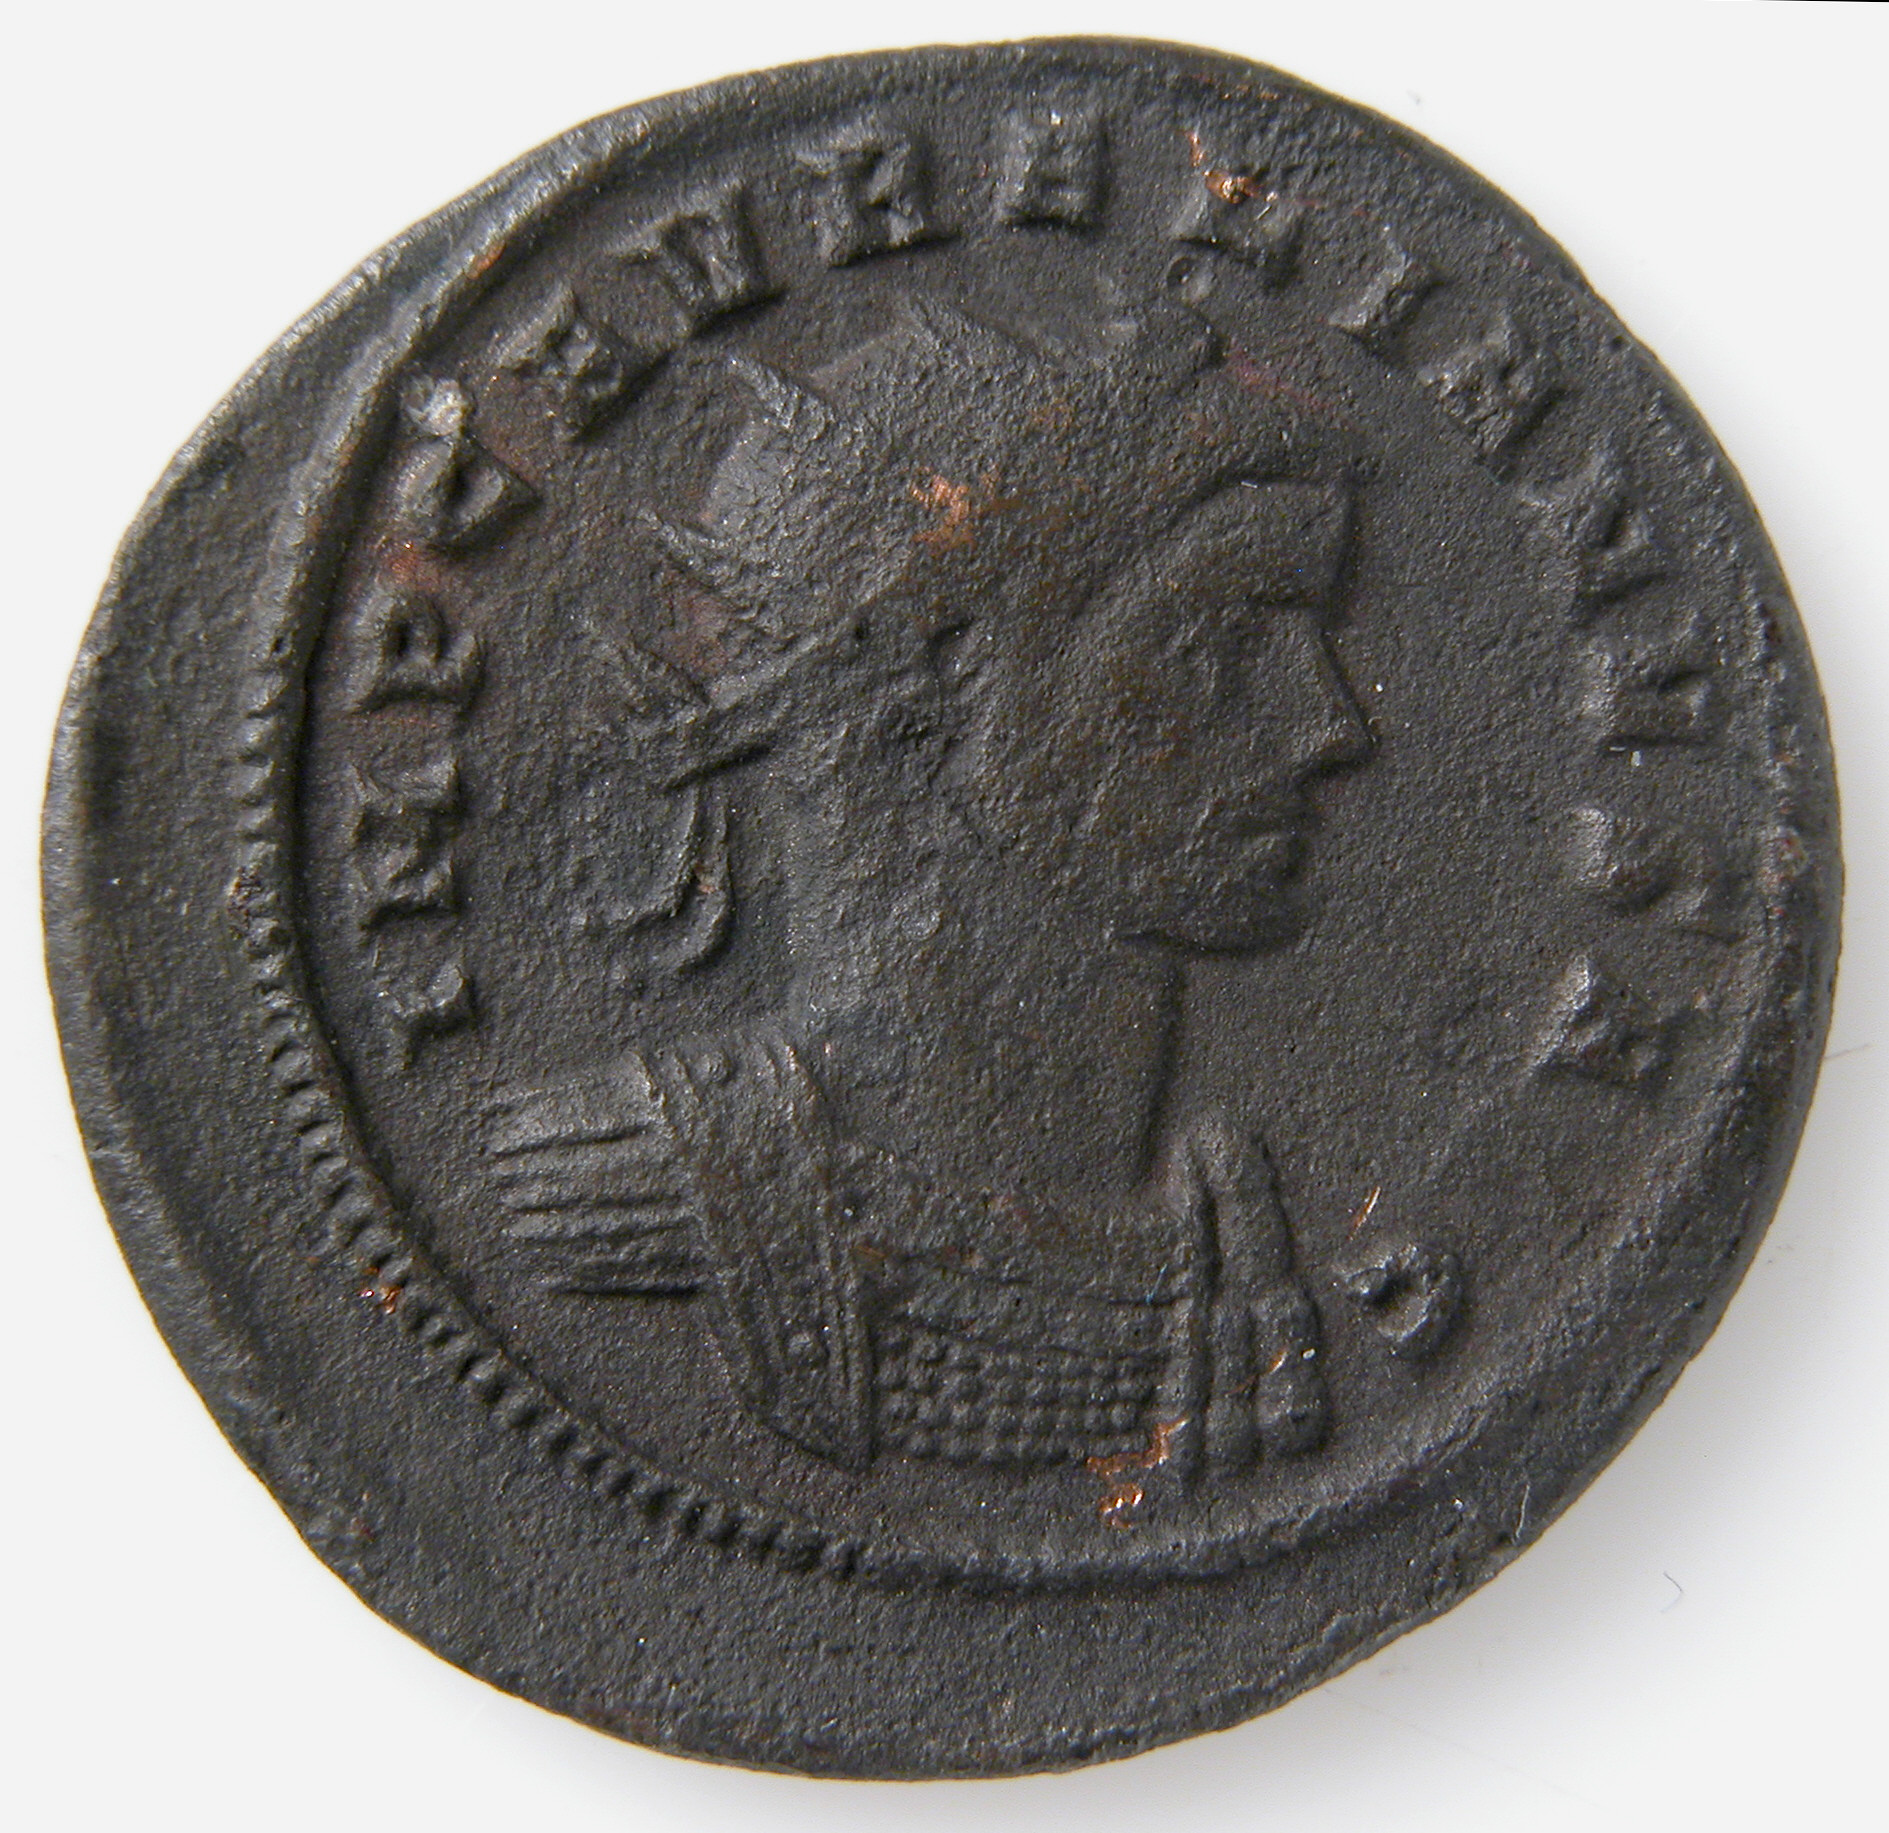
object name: coin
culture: roman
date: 270-275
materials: copper alloy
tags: men,profiles